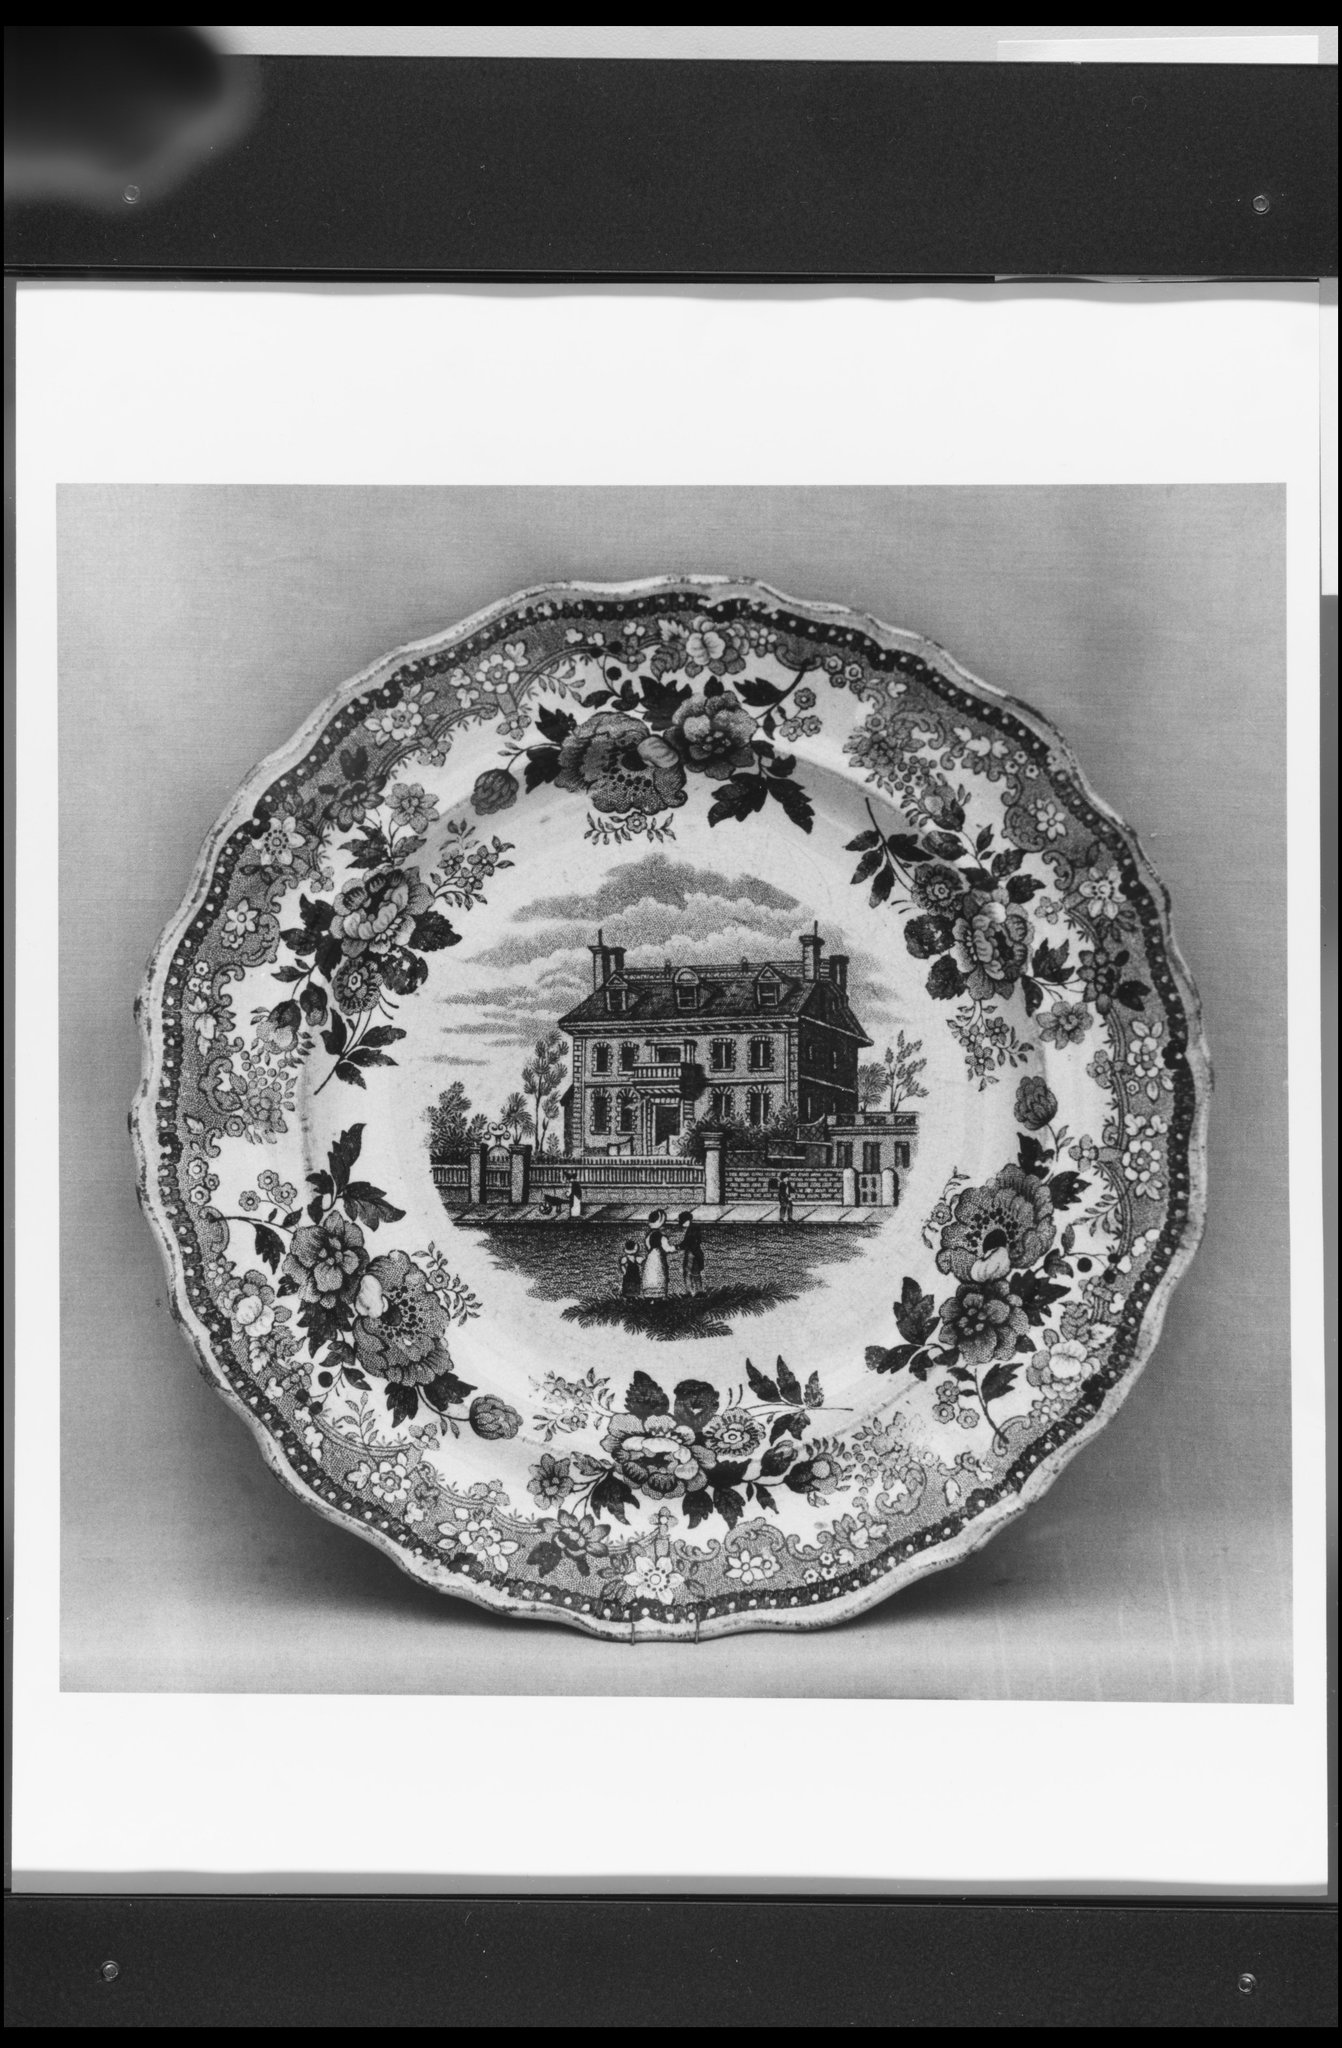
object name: plate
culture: british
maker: job & john jackson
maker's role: maker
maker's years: 1831-1835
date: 1831-1835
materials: earthenware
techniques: transfer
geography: england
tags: houses,flowers